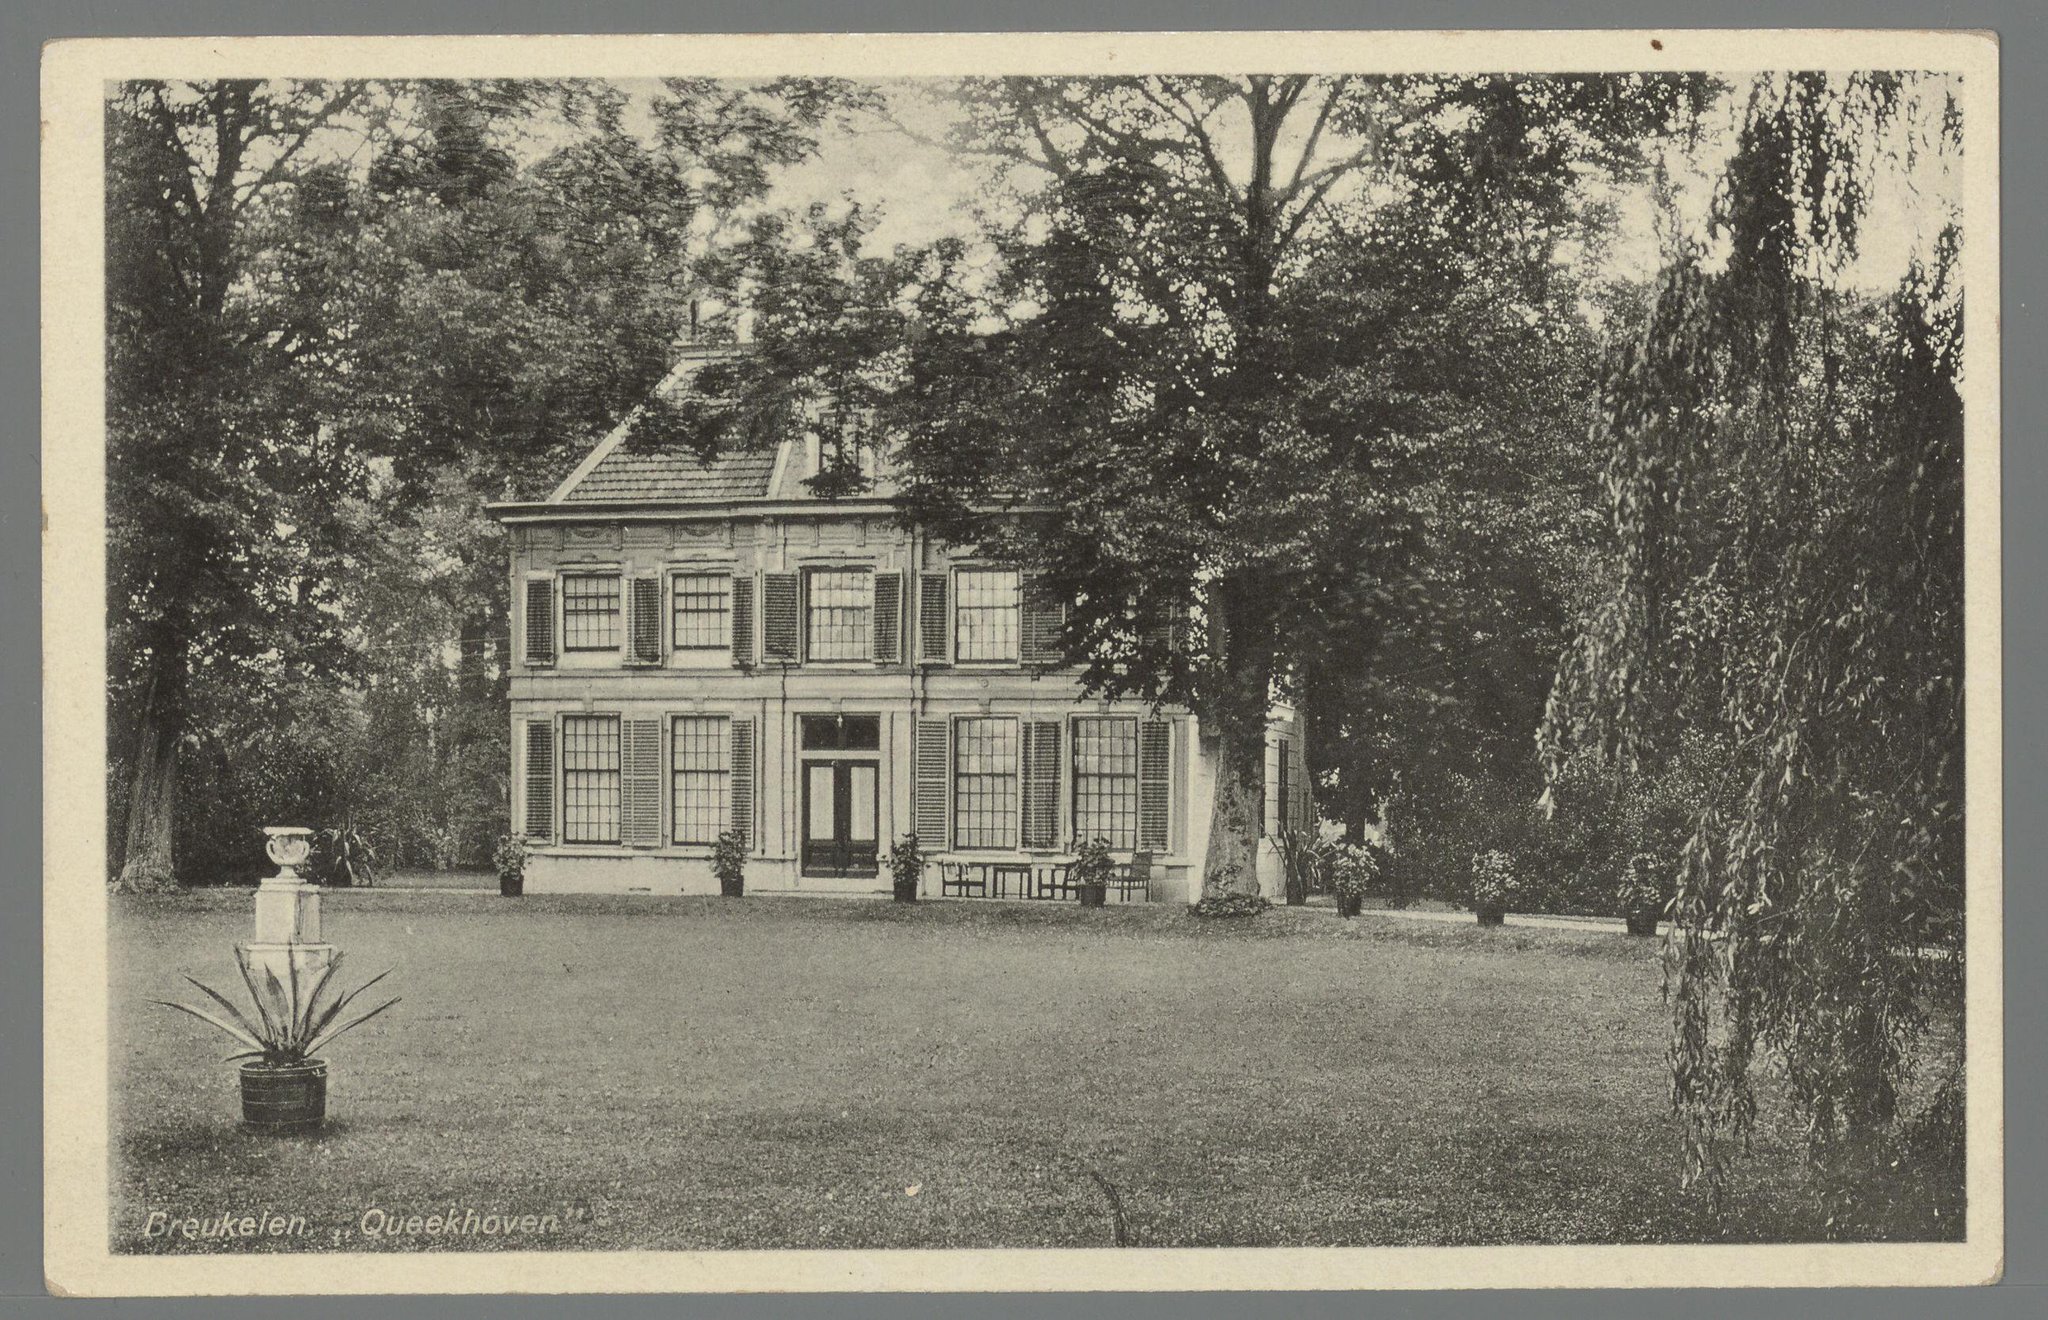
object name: ansichtkaart, prentbriefkaart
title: Breukelen. "Queekhoven"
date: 1913-1950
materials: cardboard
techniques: photograph, writing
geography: breukelen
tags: villa